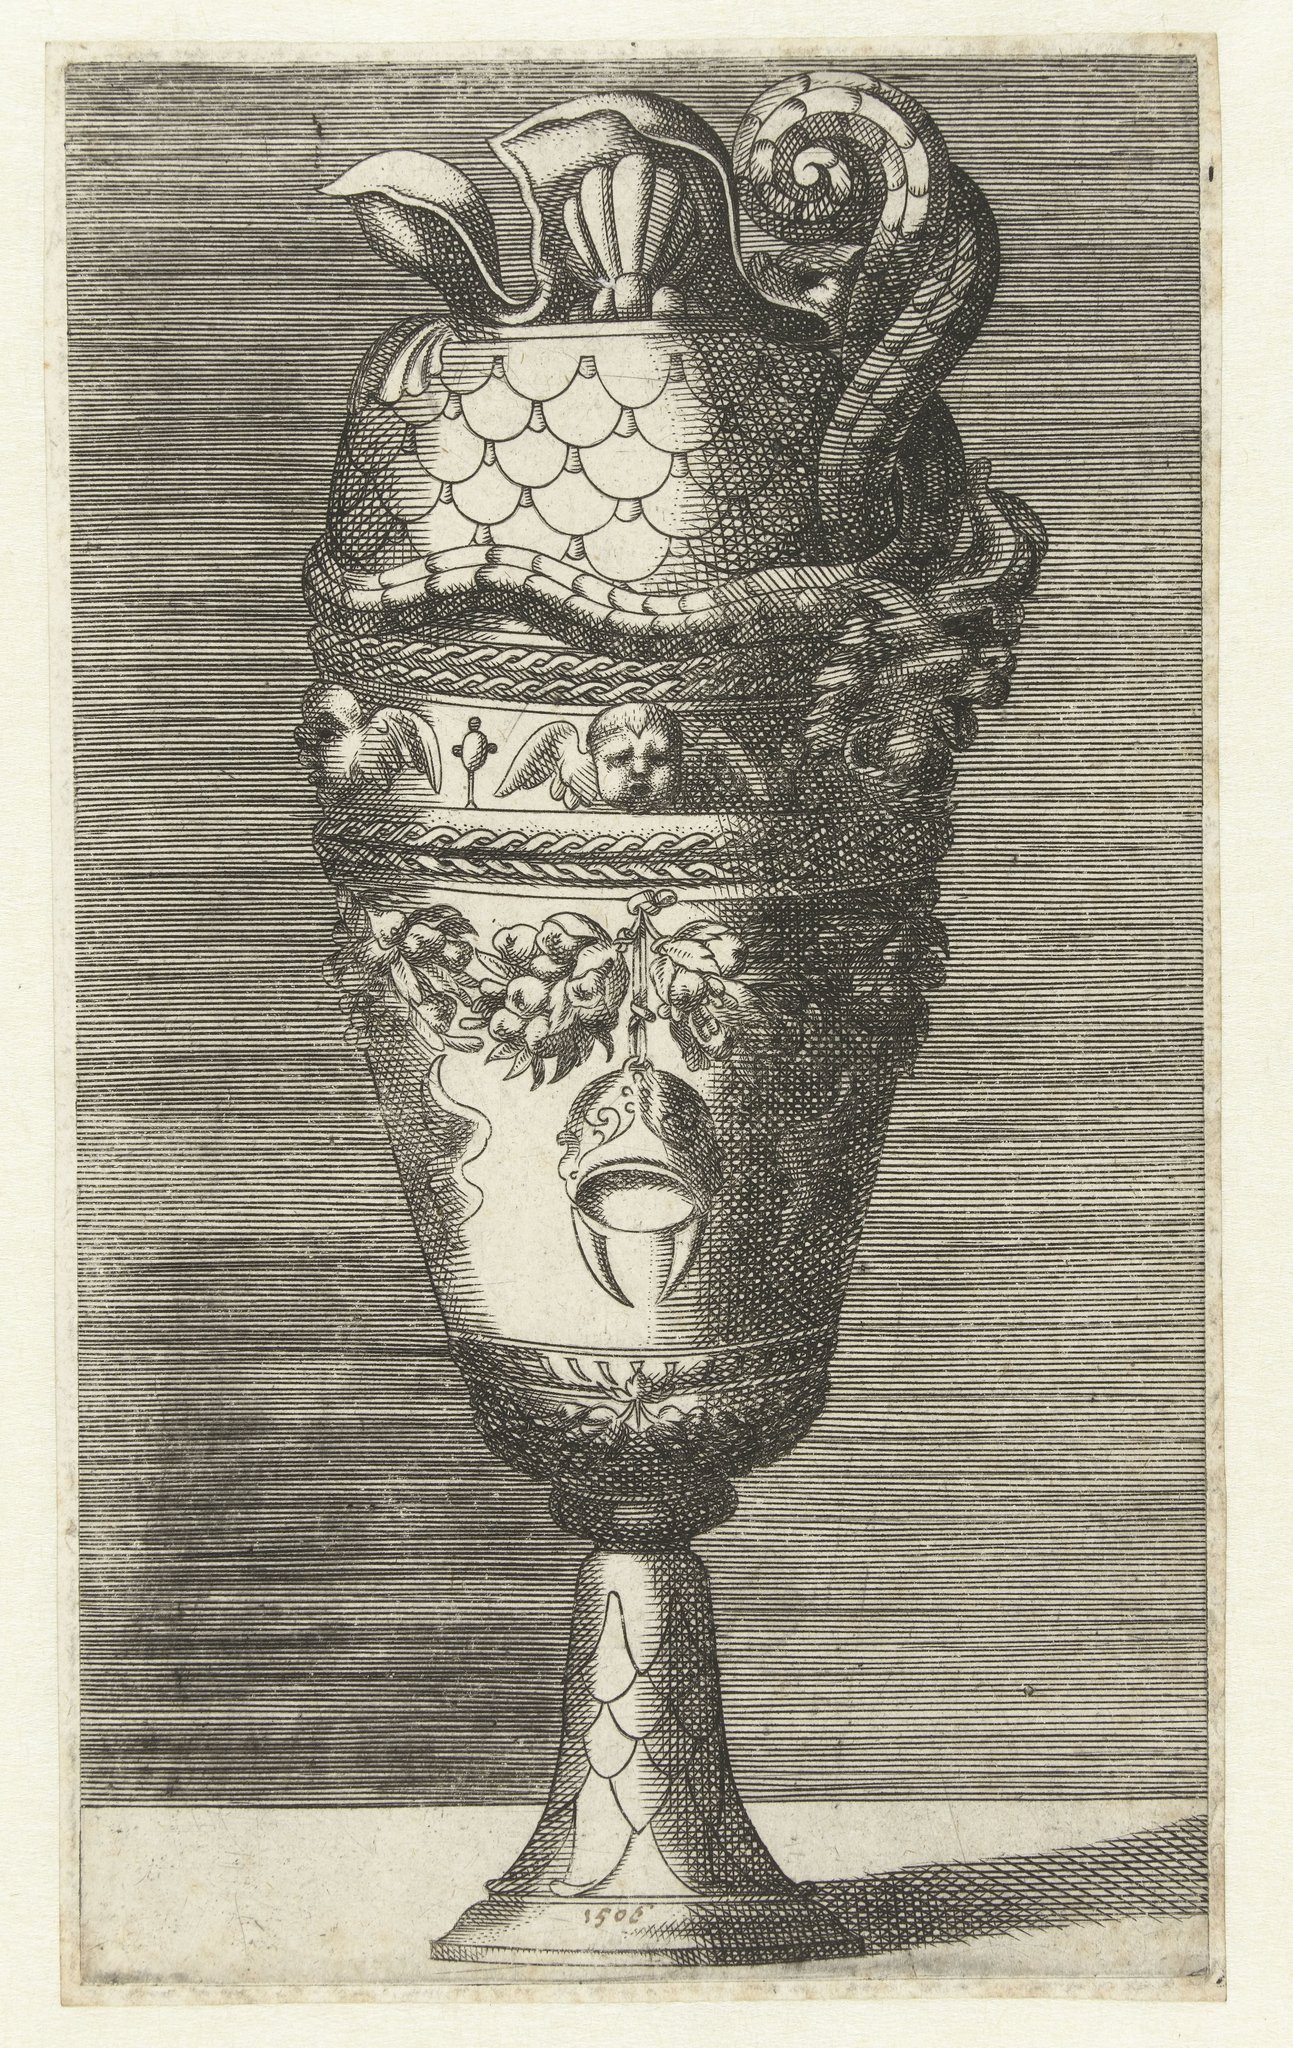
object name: print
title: Kan met een dubbel oor, bestaande uit een slang die zich in de rand vastbijt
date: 1551-1580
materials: paper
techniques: engraving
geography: france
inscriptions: inscription: ‘1506’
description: De slang ligt om de kan heen gekronkeld. De buik van de kan is gedecoreerd met guirlandes waaraan een helm hangt. Horizontaal gearceerde achtergrond. Blad uit serie van 12 bladen.